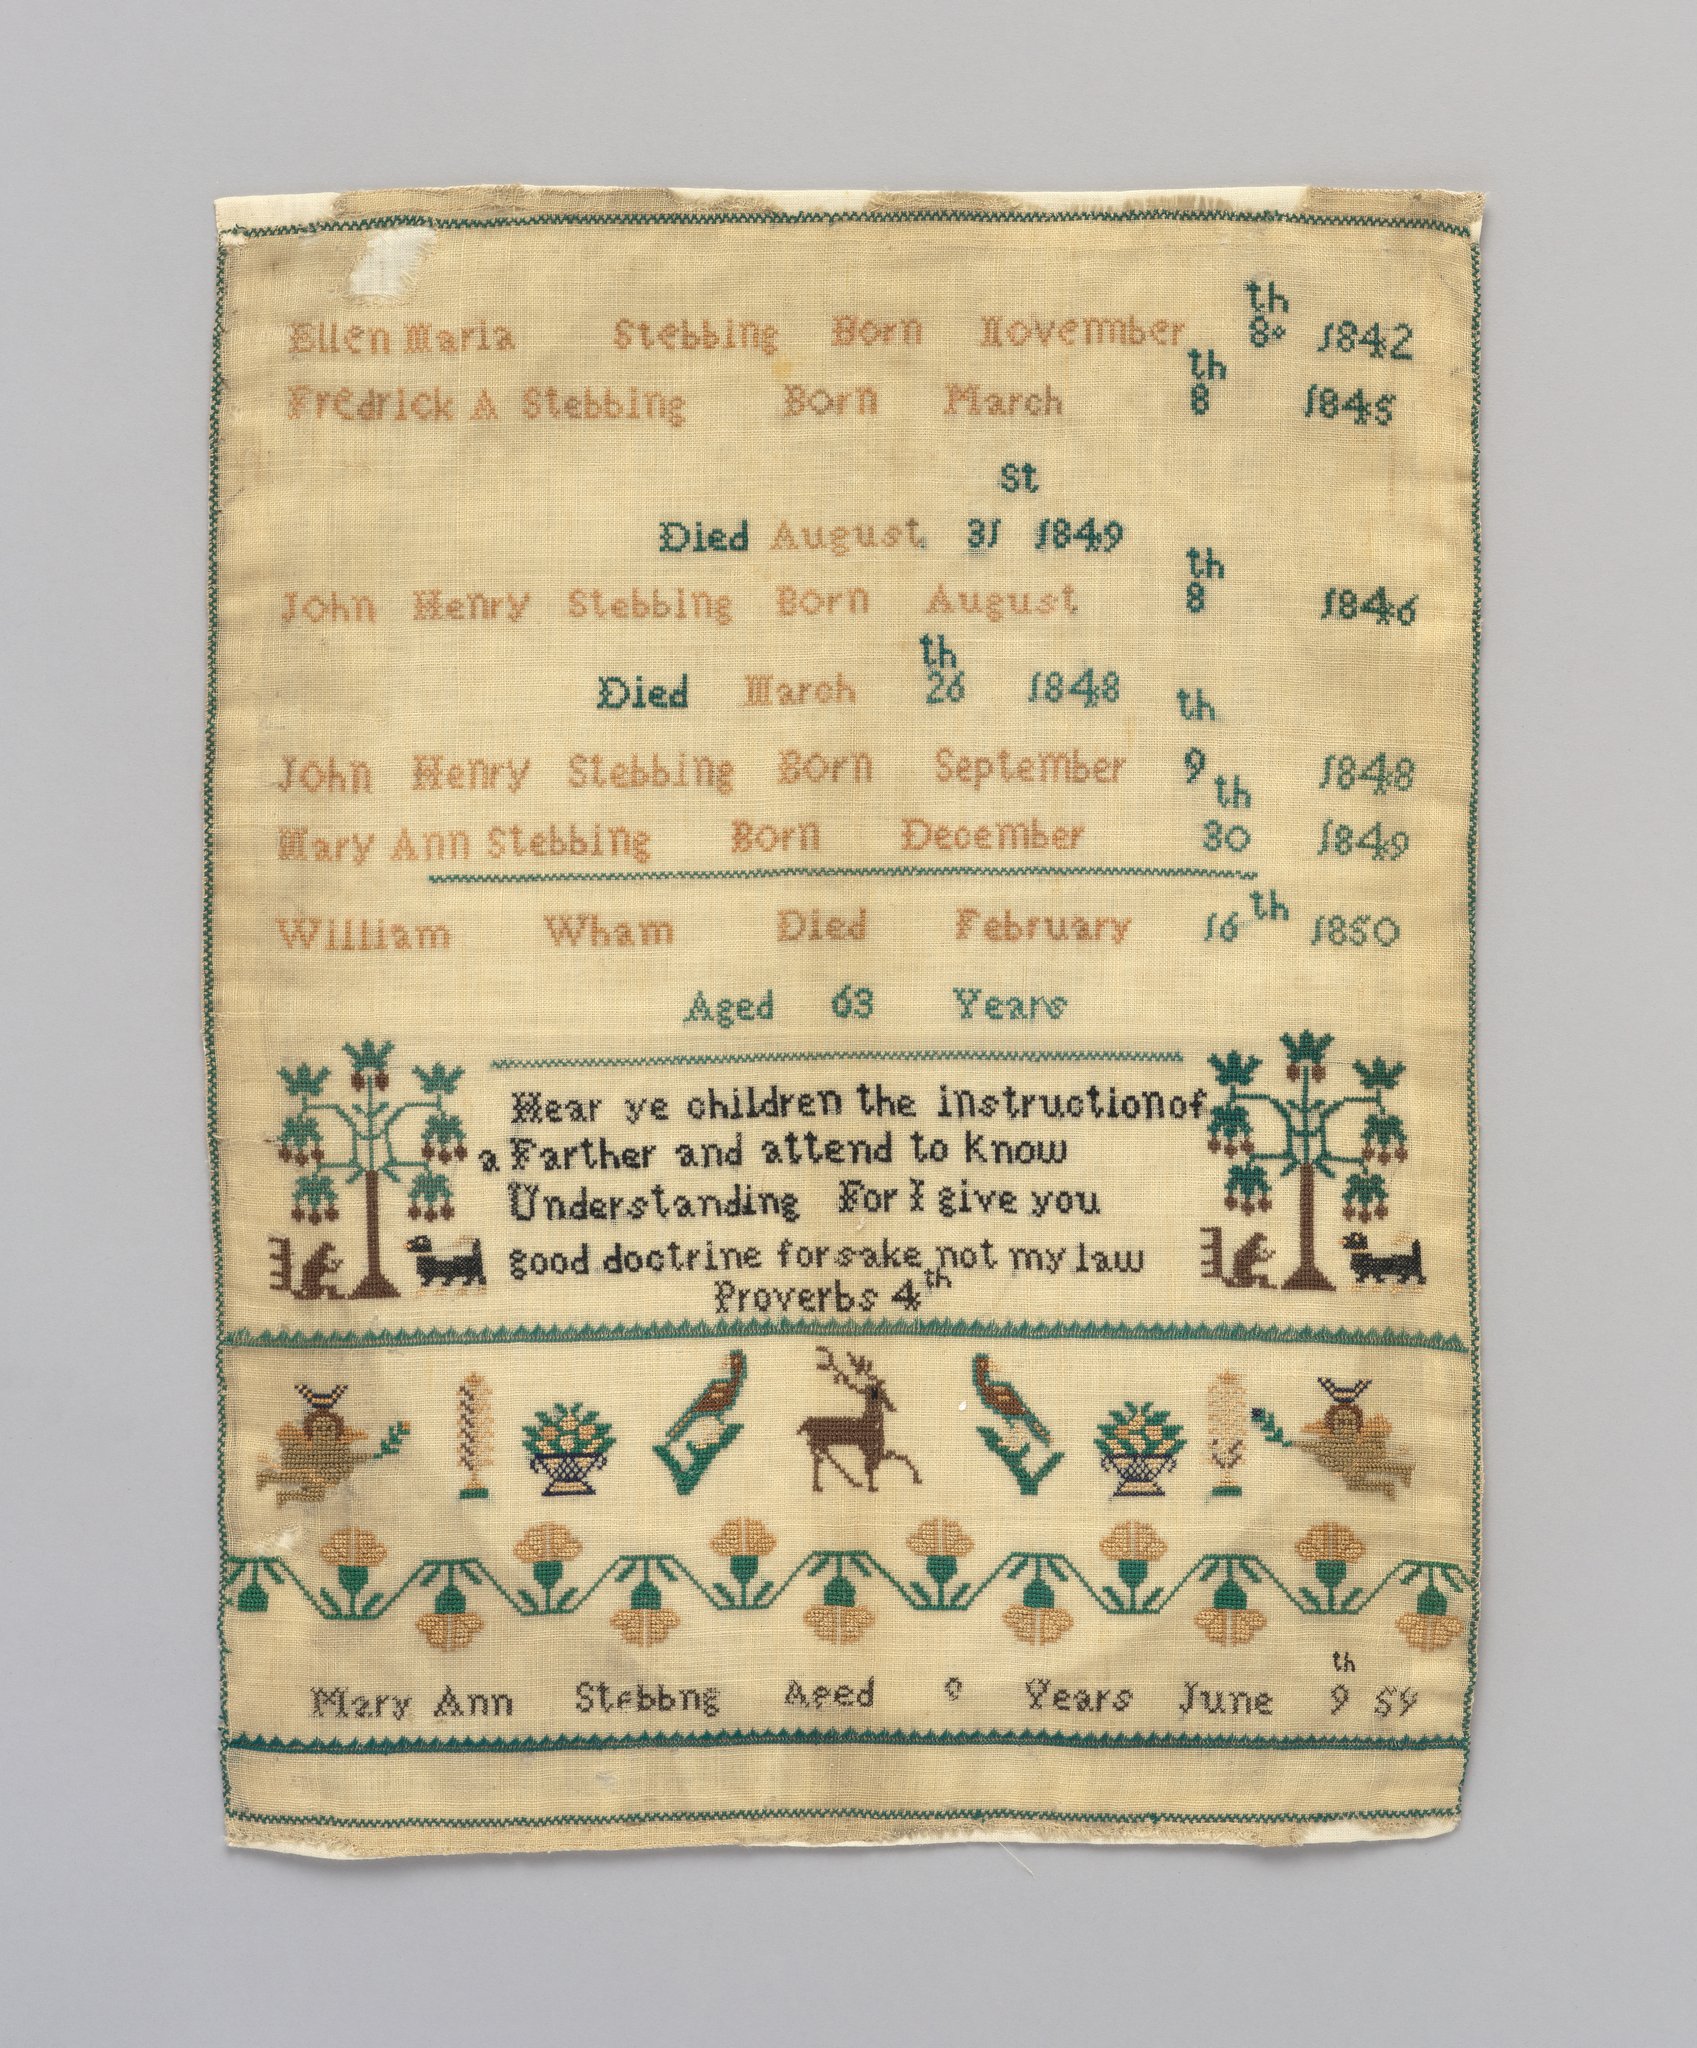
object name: sampler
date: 1859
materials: canvas, silk, wool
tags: birds,deer